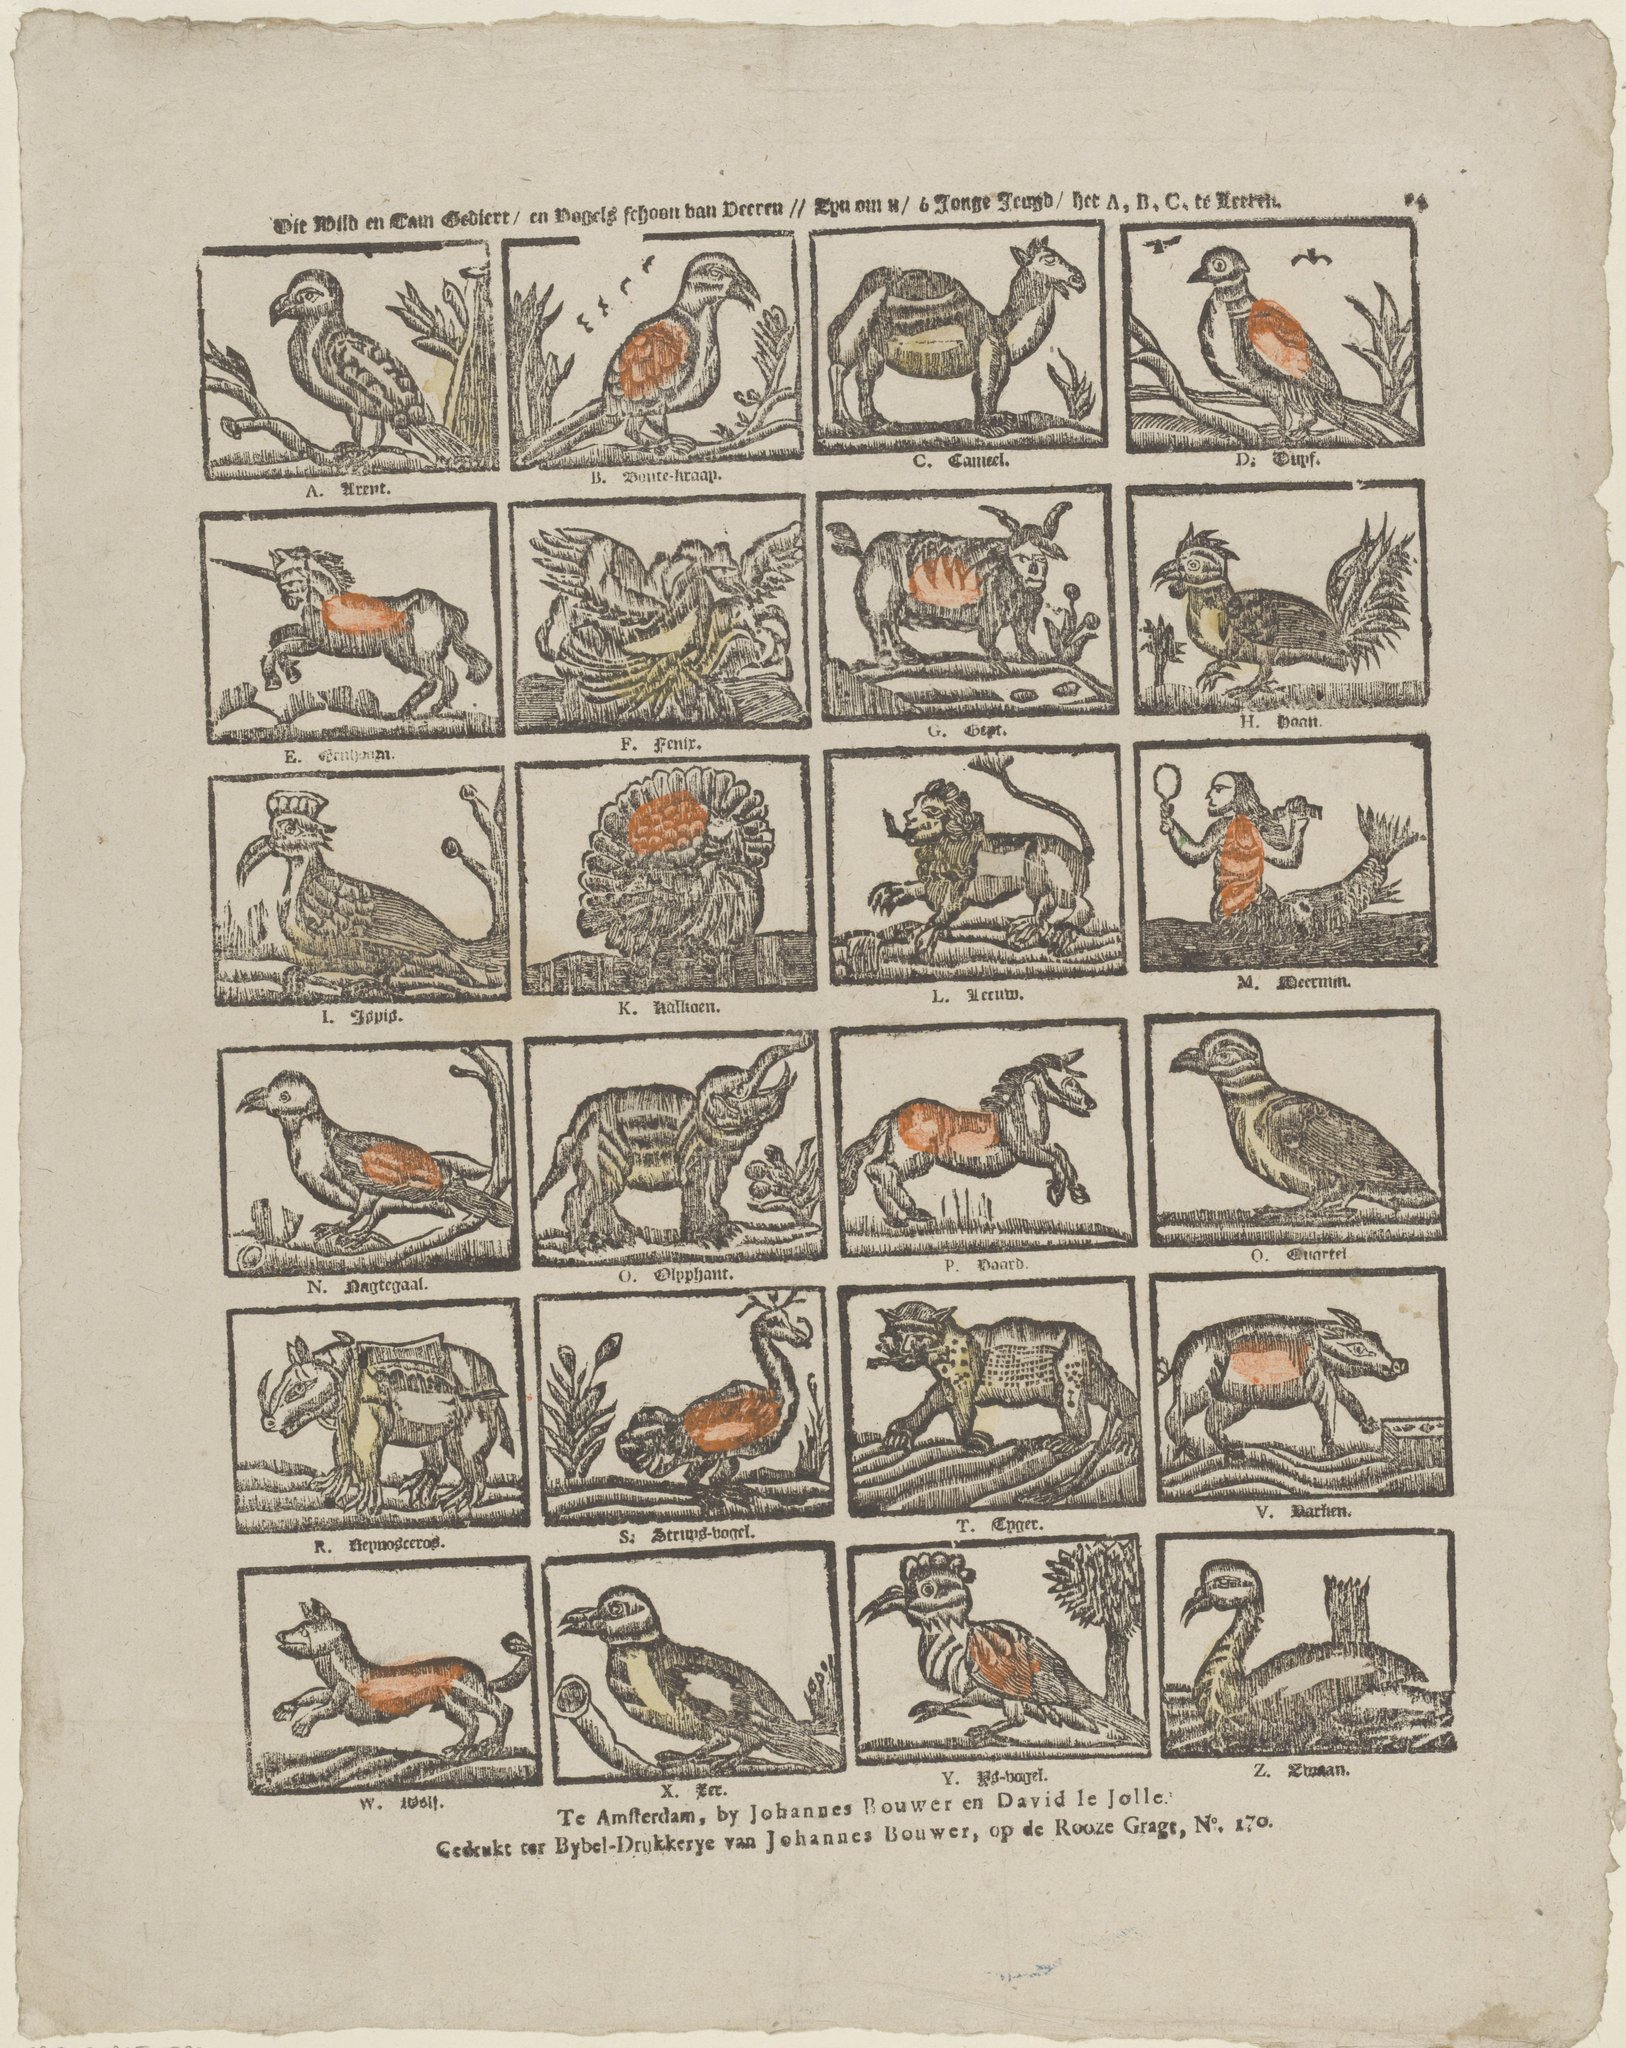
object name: print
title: Dit wild en tam gediert / en vogels schoon van veeren // Zijn om u / ô jonge jeugd / het A, B, C, te leeren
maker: Anonymous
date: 1809-1814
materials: paper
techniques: colour, letterpress printing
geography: amsterdam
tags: fabulous animals (sometimes wrongly called 'grotesques'); 'mostri' (ripa), animals, letters, alphabet, script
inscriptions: collector's mark: Lugt 2760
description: Blad met 24 voorstellingen voorstellingen van de letters van het alfabet geïllustreerd met dieren waarvan de namen met de betreffende letter beginnen. Onder elke afbeelding een onderschrift. Genummerd rechtsboven: 24.